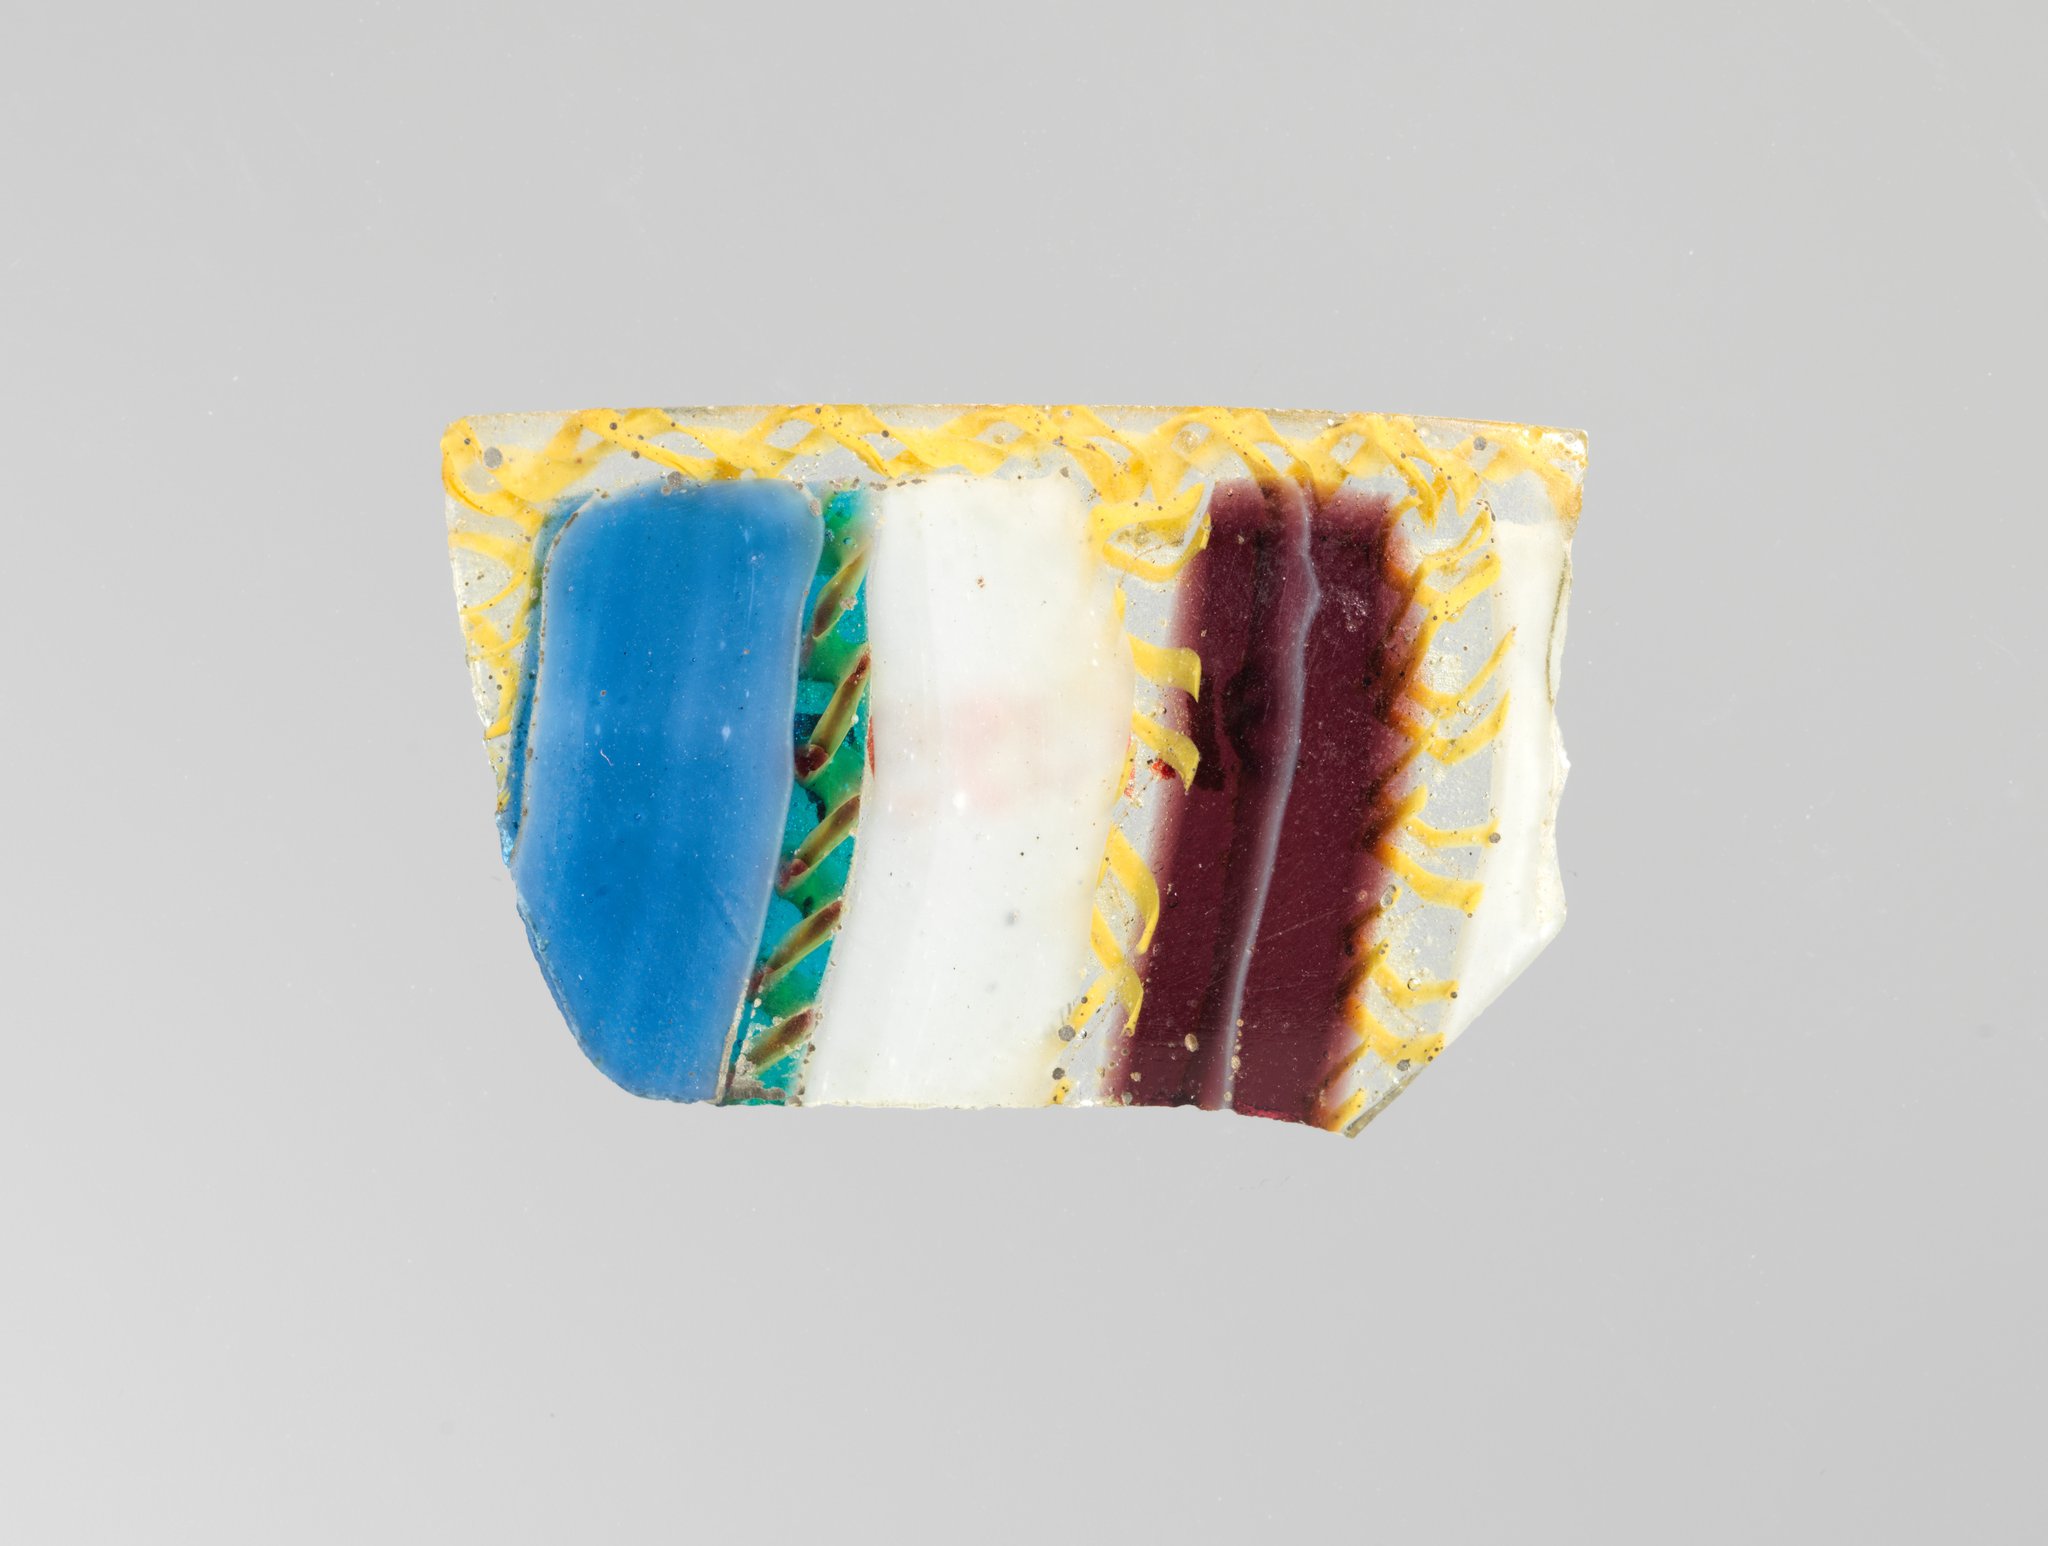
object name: fragment, striped mosaic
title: Glass striped mosaic bowl fragment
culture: roman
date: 34 BCE-33 CE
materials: glass